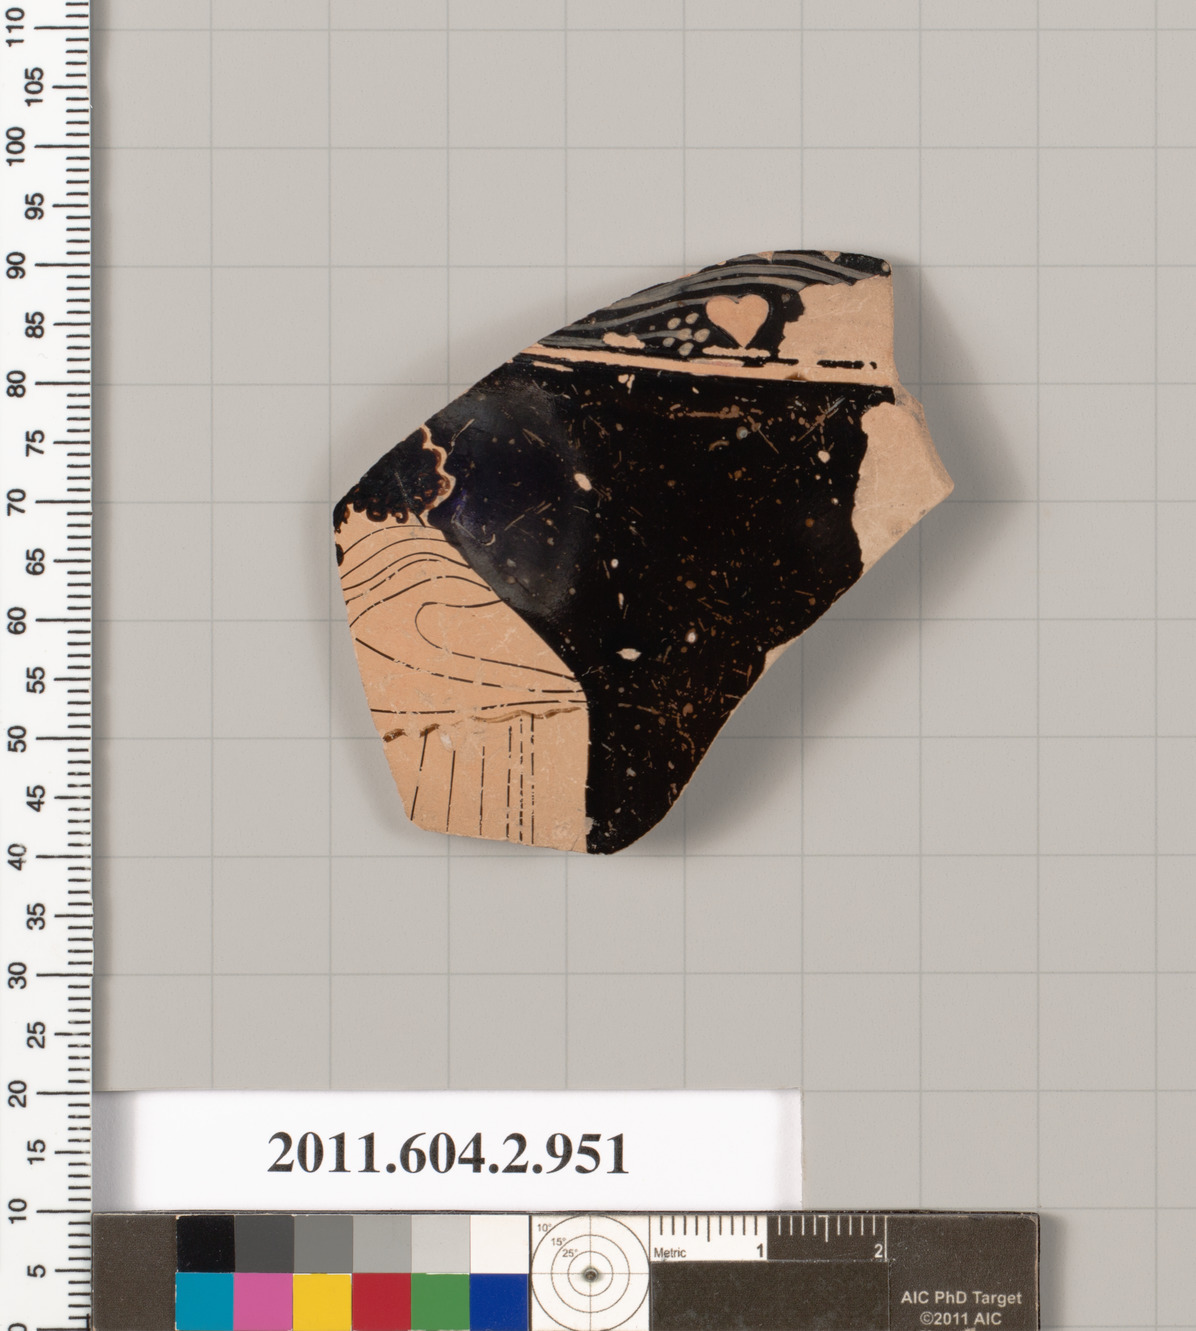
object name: oinochoe fragment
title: Terracotta fragment of an oinochoe (jug)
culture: greek, attic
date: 460-440 BCE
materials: terracotta